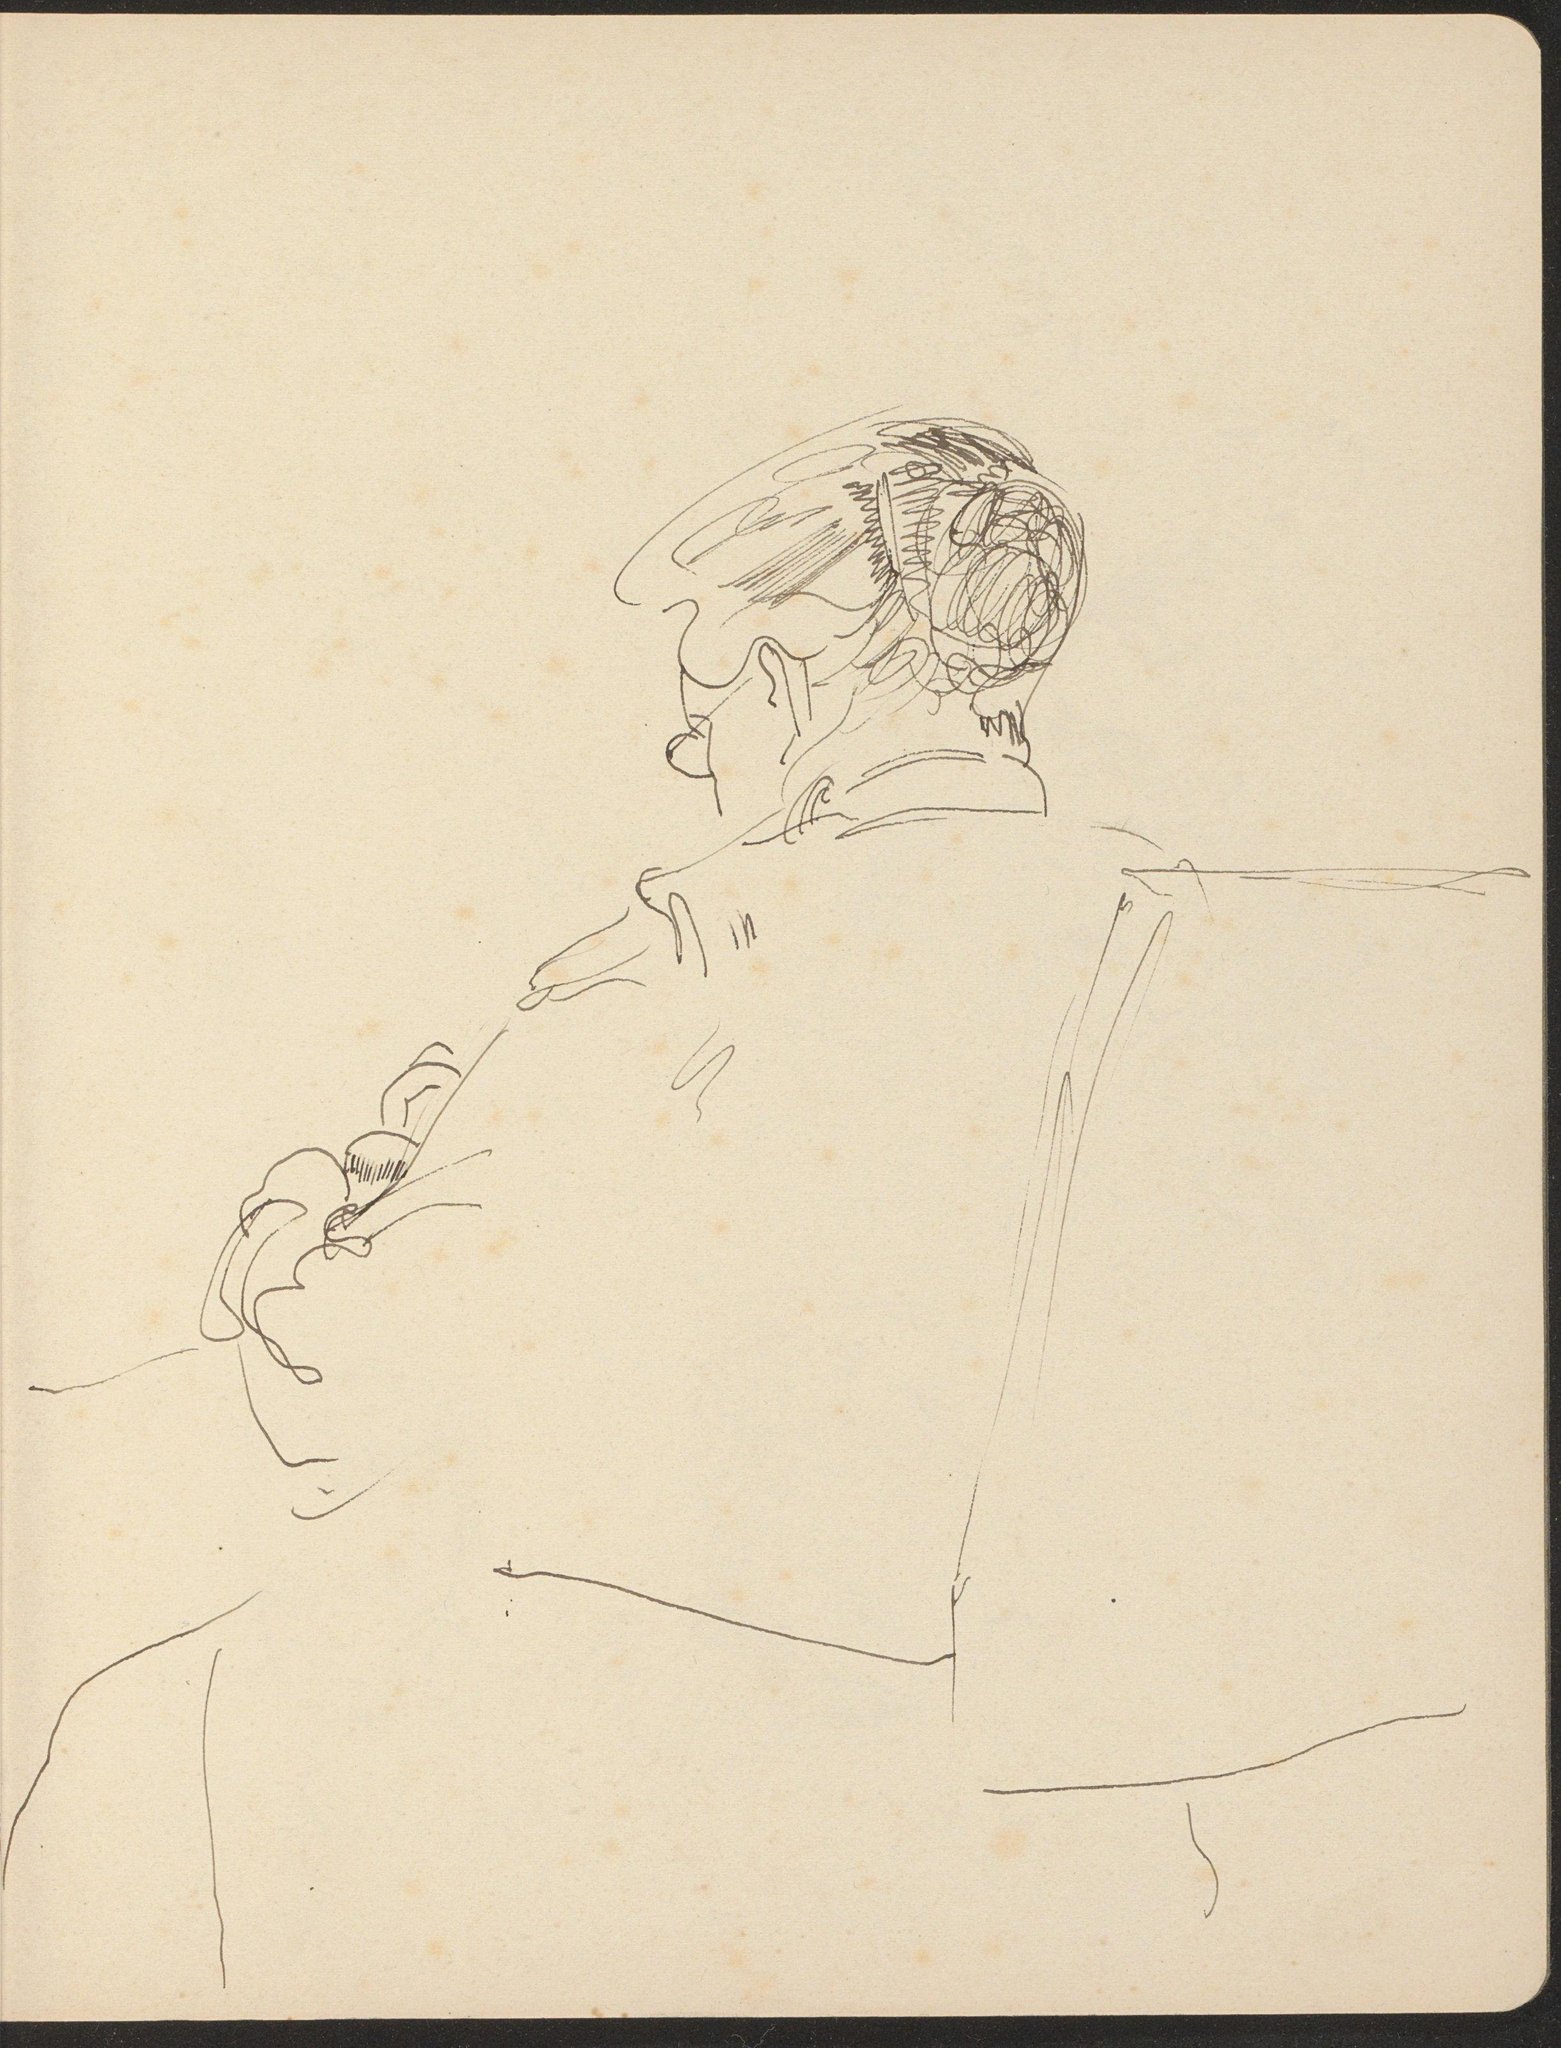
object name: sketchbook leaf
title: Handwerkende vrouw in een stoel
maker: carel adolph lion cachet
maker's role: draughtsman, print maker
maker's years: 1864-1945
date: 1930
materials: ink, paper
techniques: pen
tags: armchair, seat, sitting figure, home sewing; repair of clothes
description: Vermoedelijk de echtgenote van de kunstenaar. Blad 9 recto uit een schetsboek met 9 bladen.